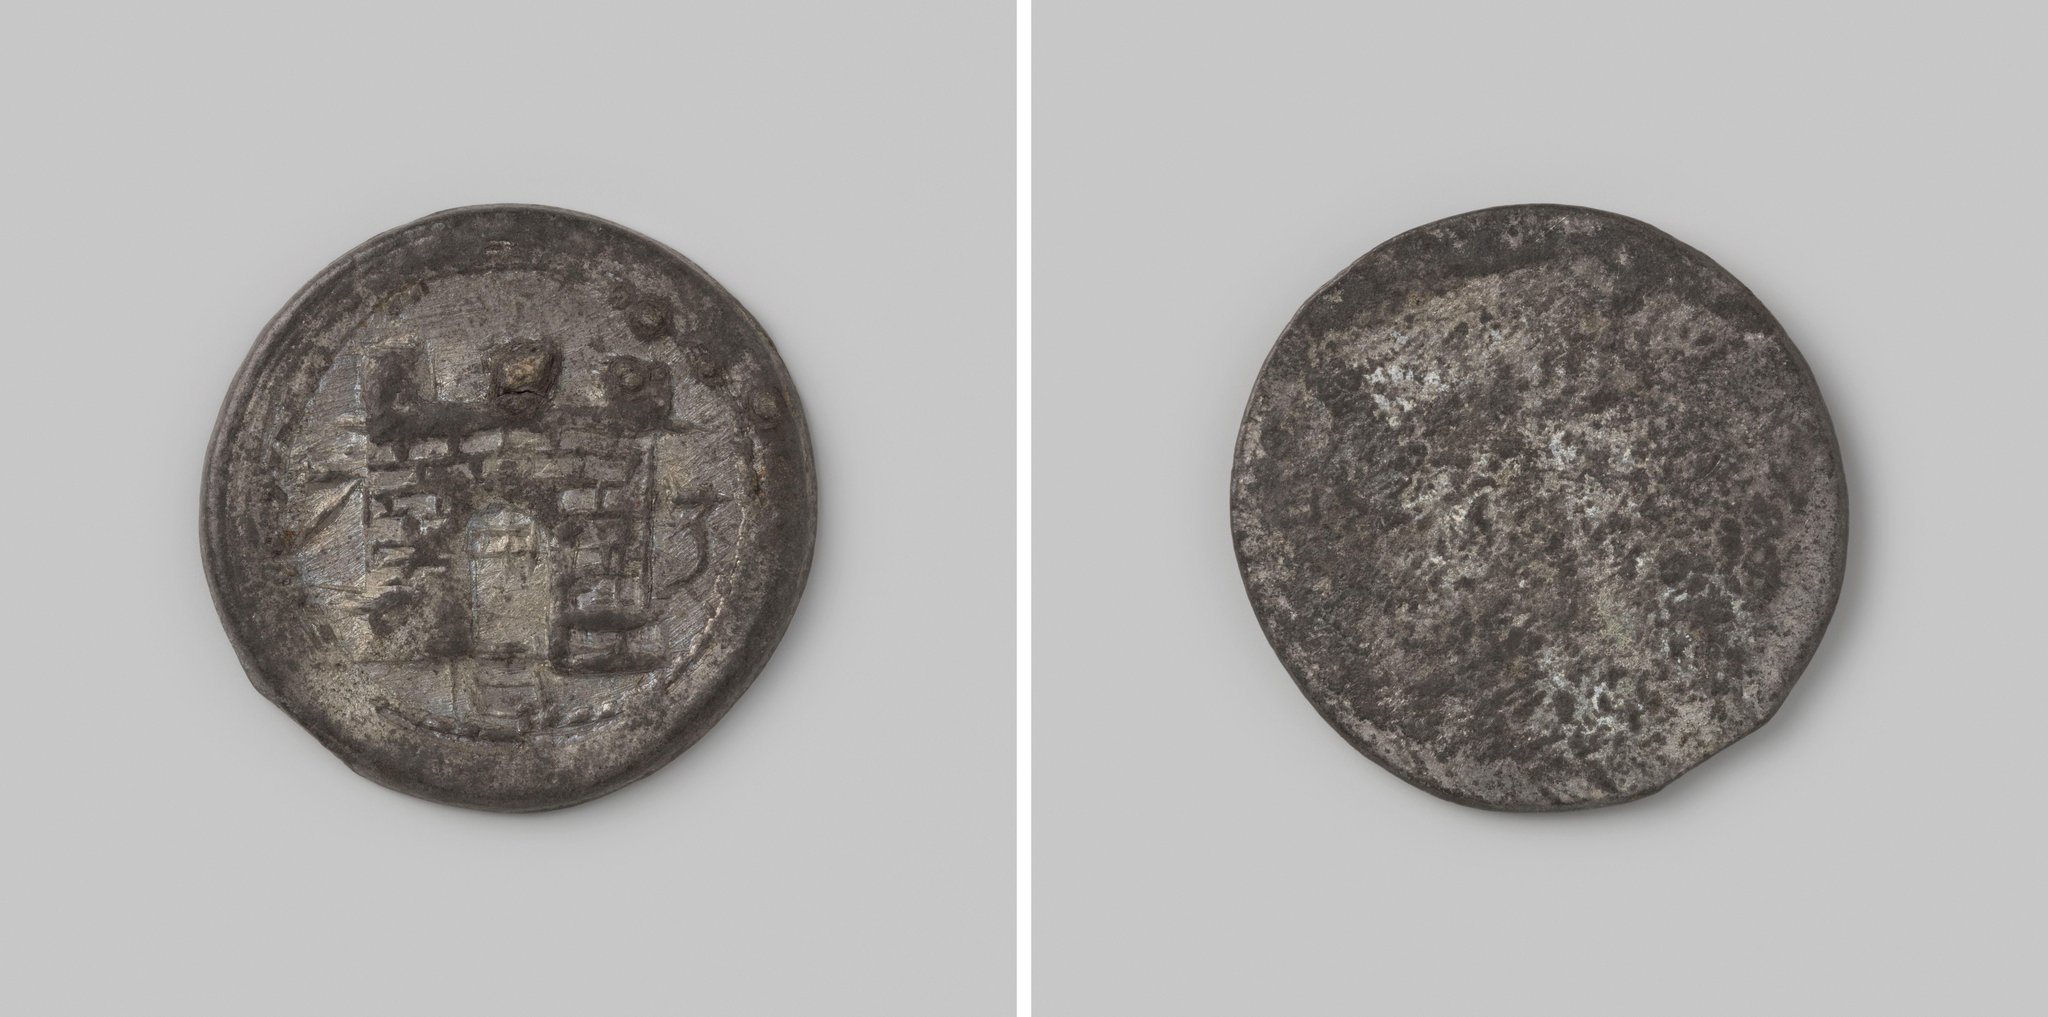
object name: siege coin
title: Kwart daalder, noodmunt uit Alkmaar, geslagen tijdens het beleg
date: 1573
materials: tin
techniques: casting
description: Tinnen noodmunt. Voorzijde: tussen 7 3 burcht. Keerzijde: glad. Vals, later werk.